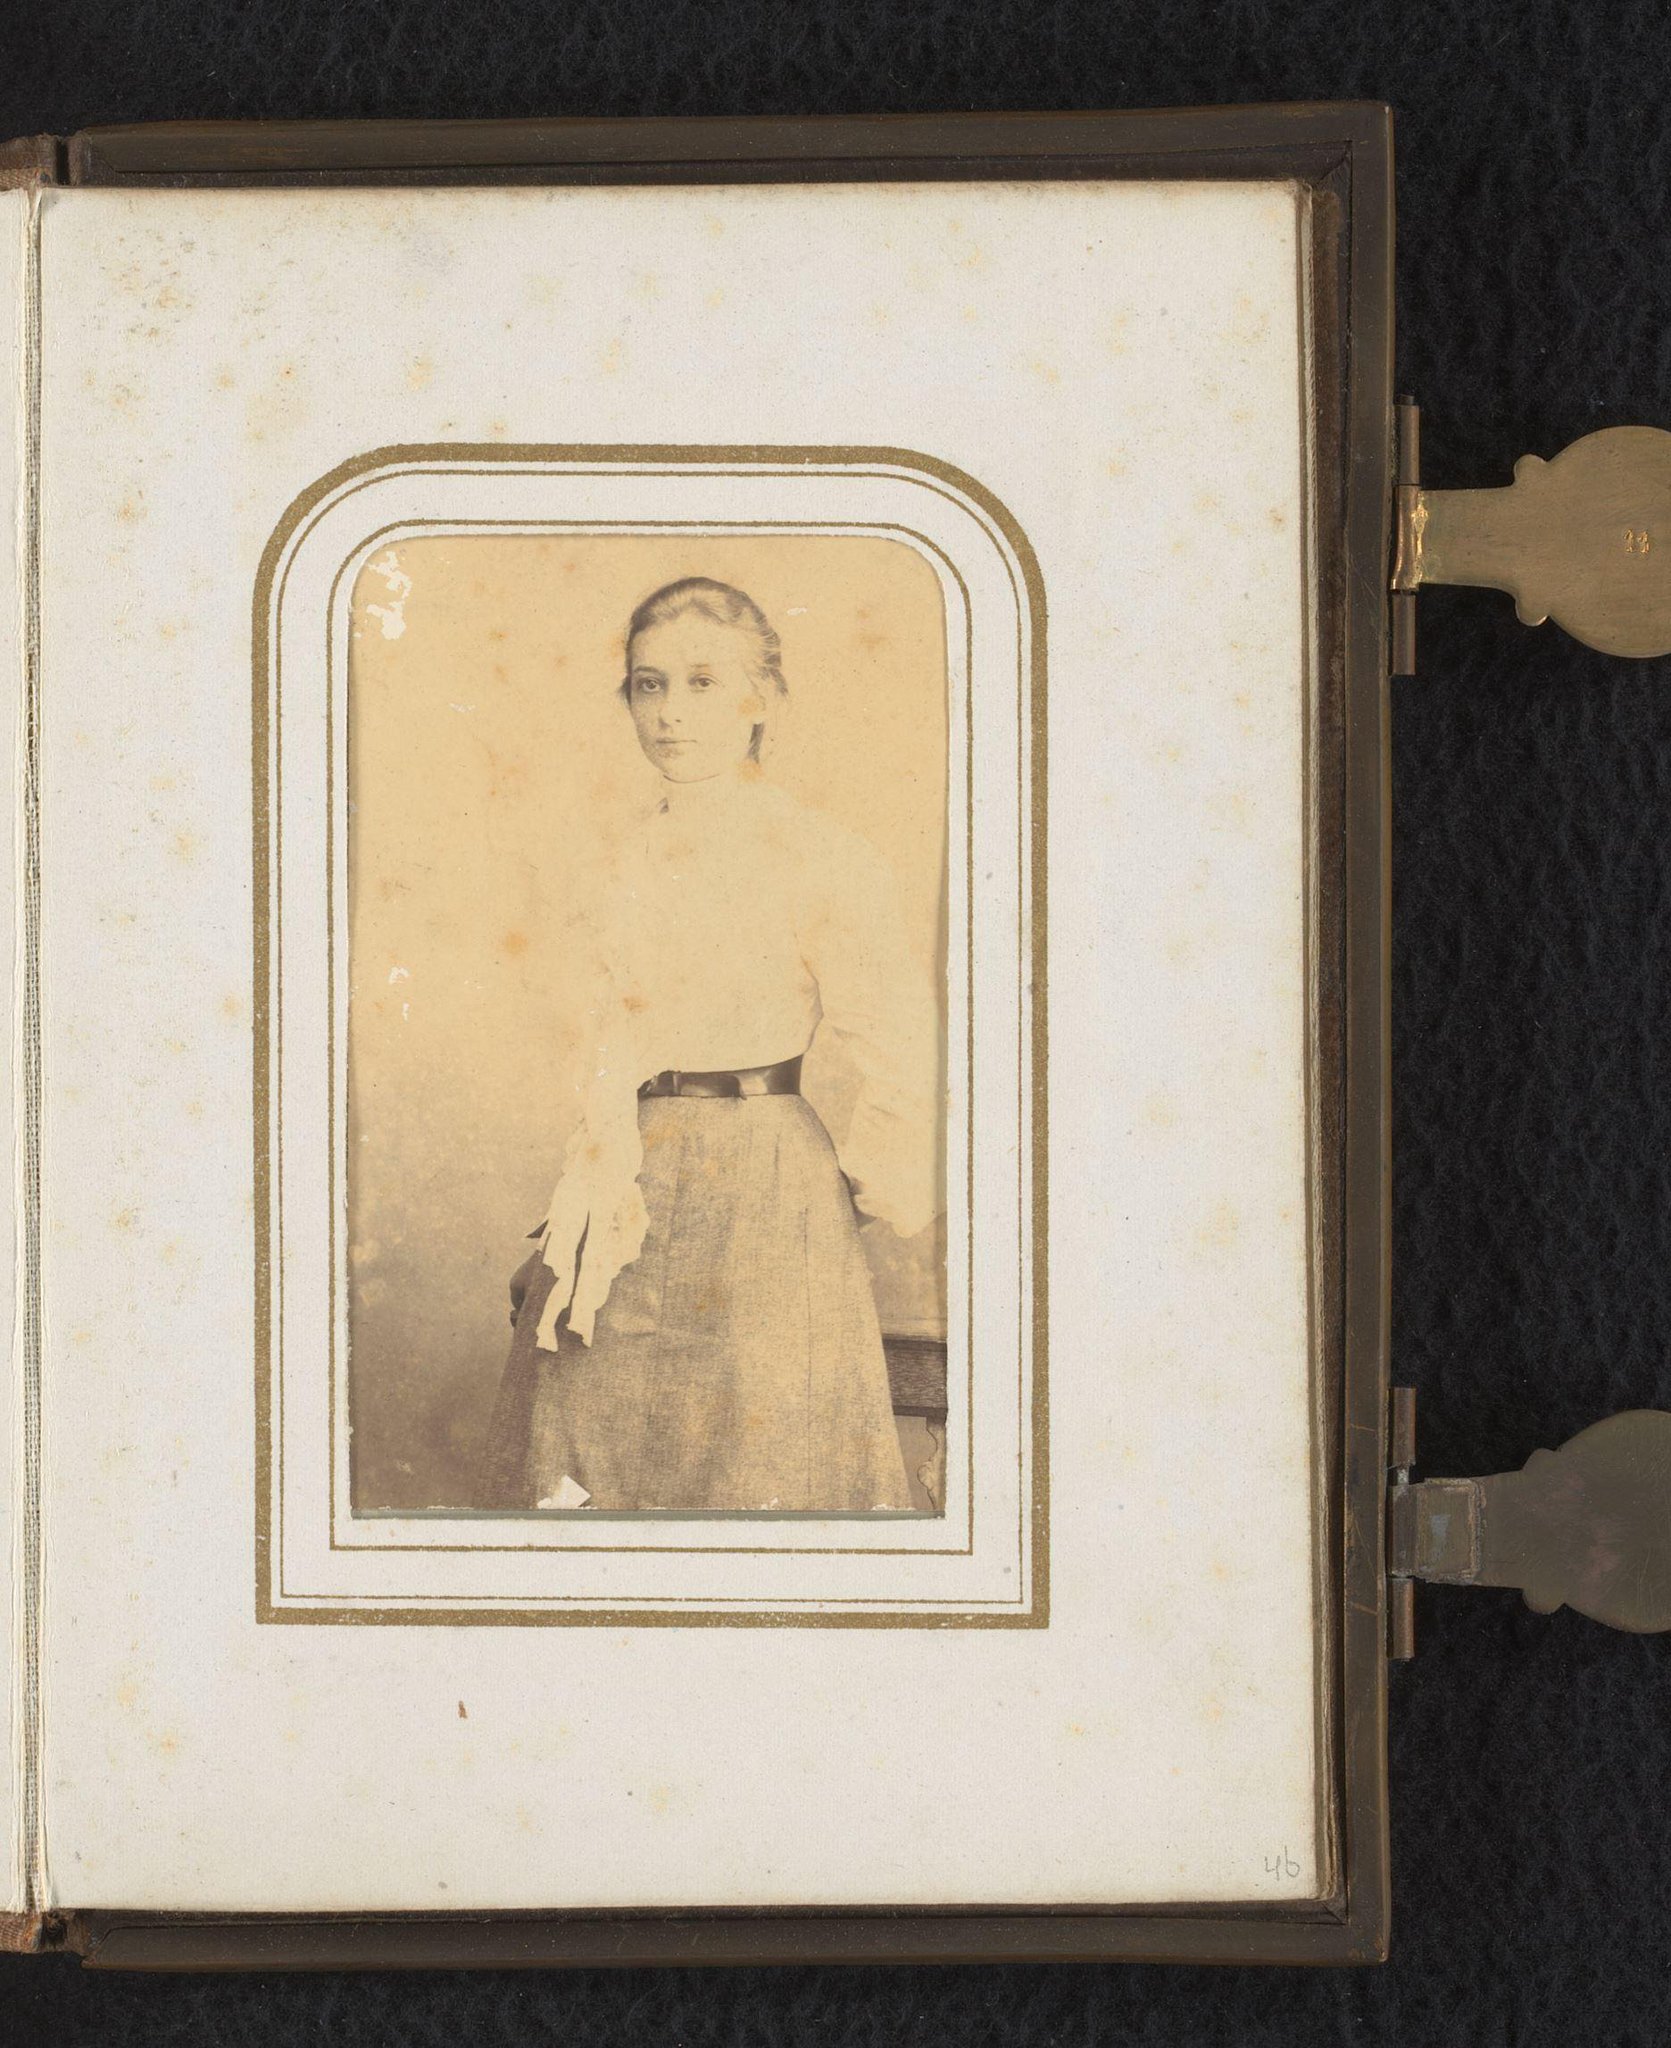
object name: photograph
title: Portret van een meisje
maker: lie eng sip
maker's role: fotograaf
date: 1870-1910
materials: cardboard, photographic support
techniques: daylight paper print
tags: historical persons, girl (child between toddler and youth)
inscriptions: inscription: ‘Lie Eng Sip/ Photograaf/ Padang’